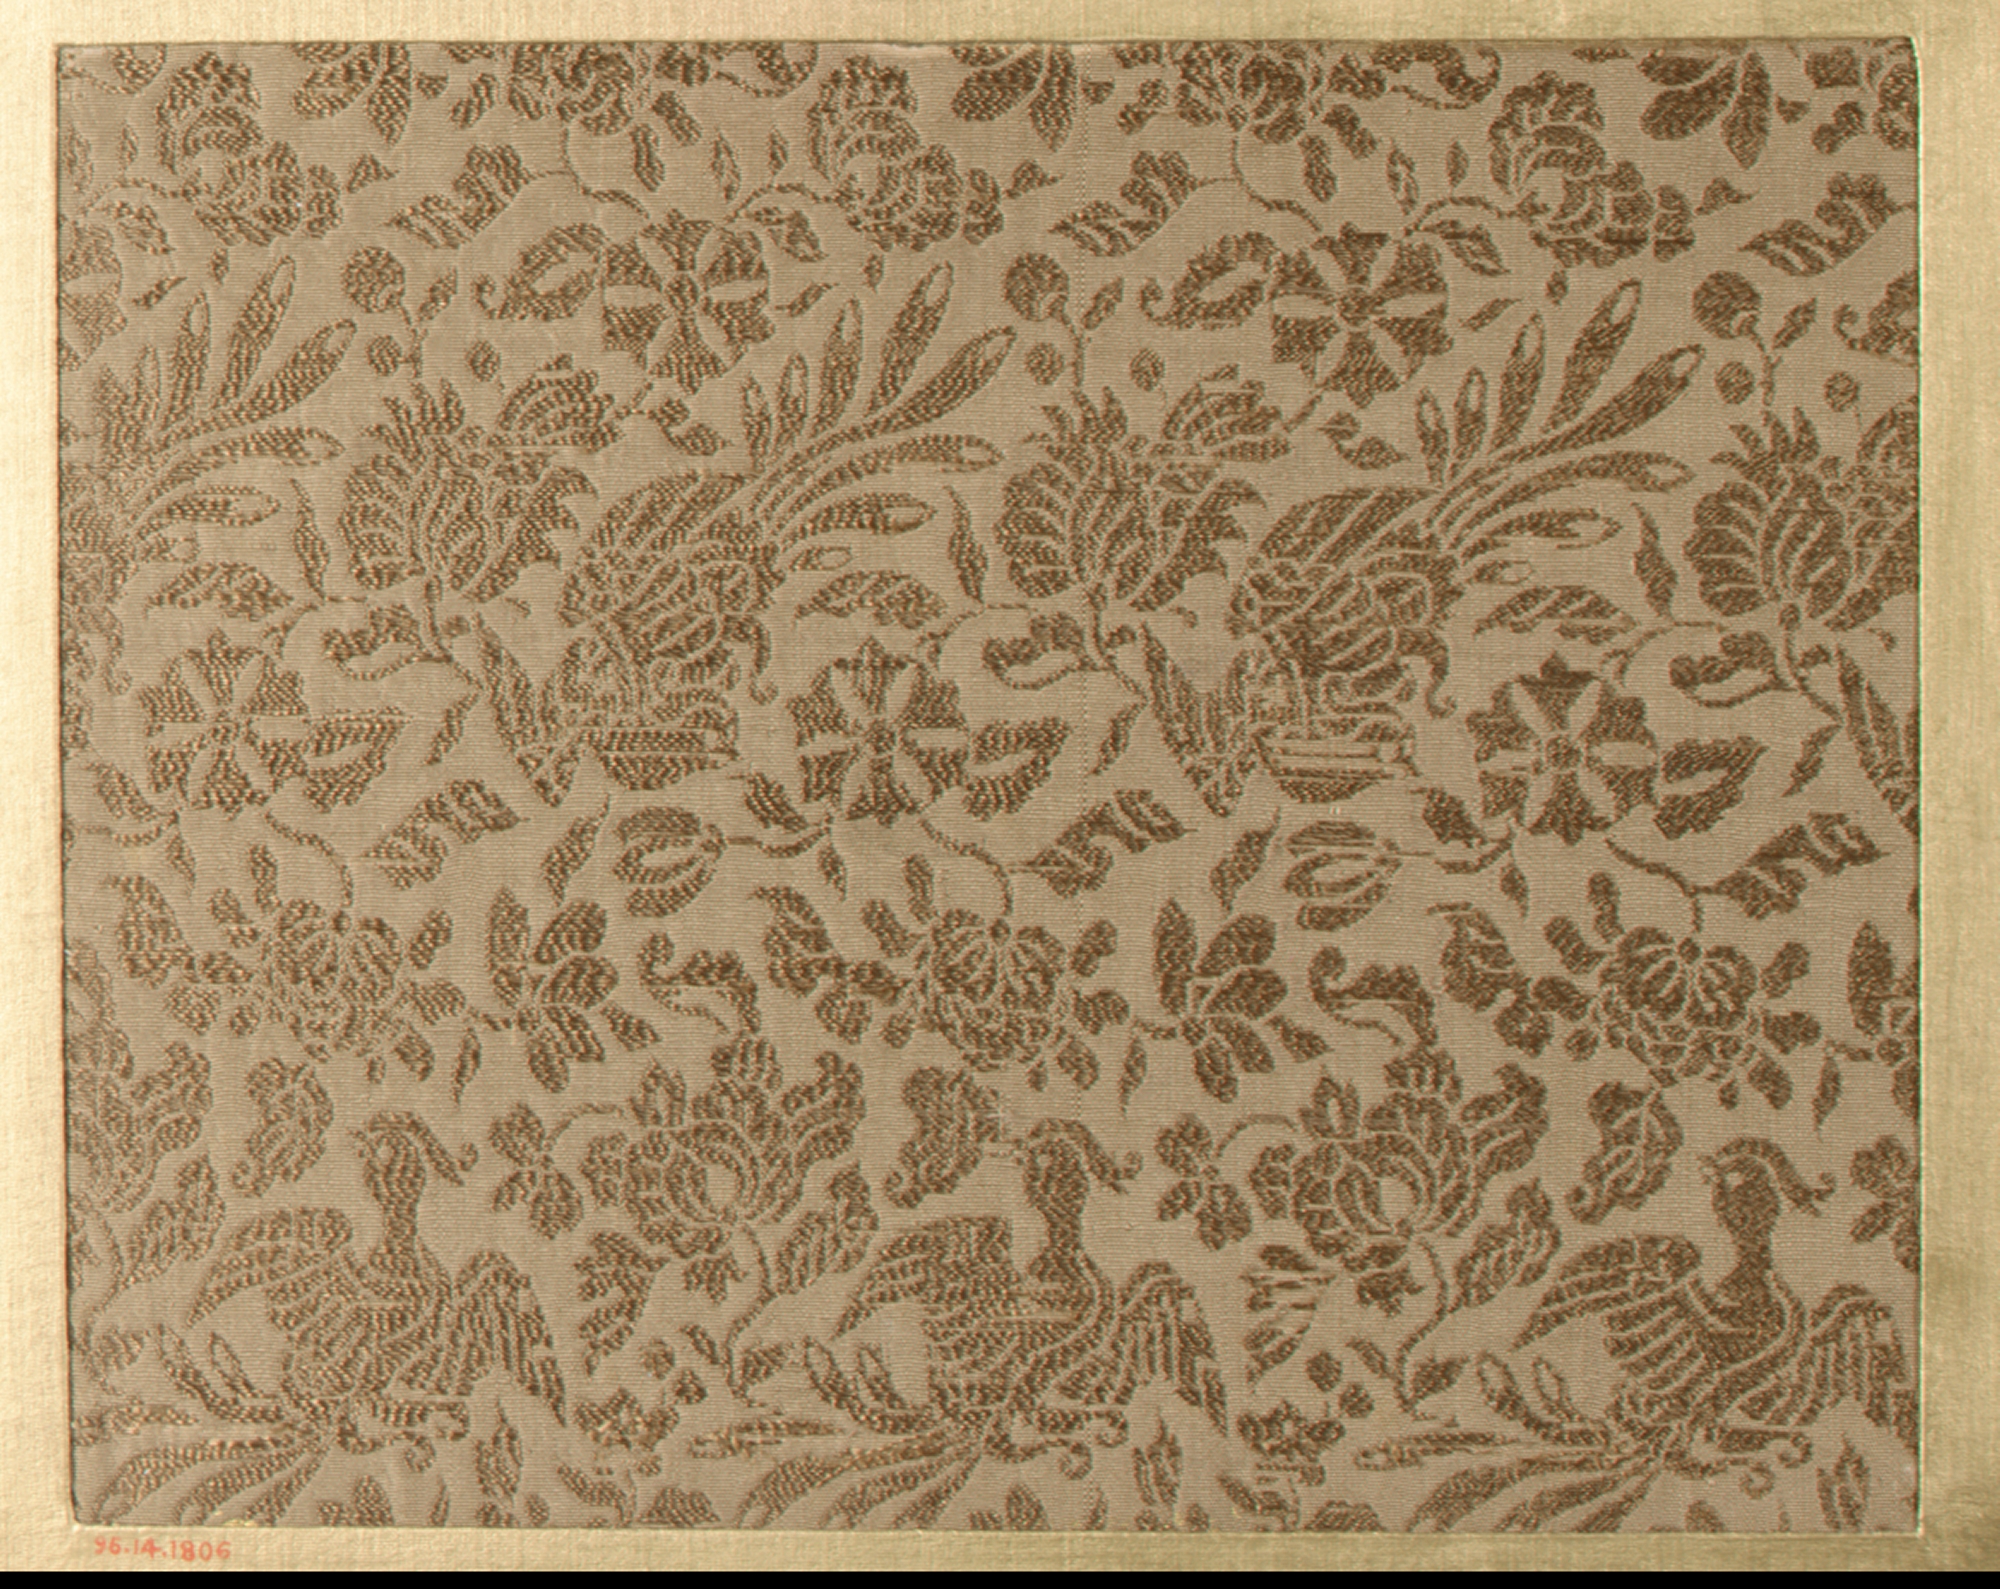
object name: piece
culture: japanese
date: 1701-1900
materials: silk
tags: birds,flowers